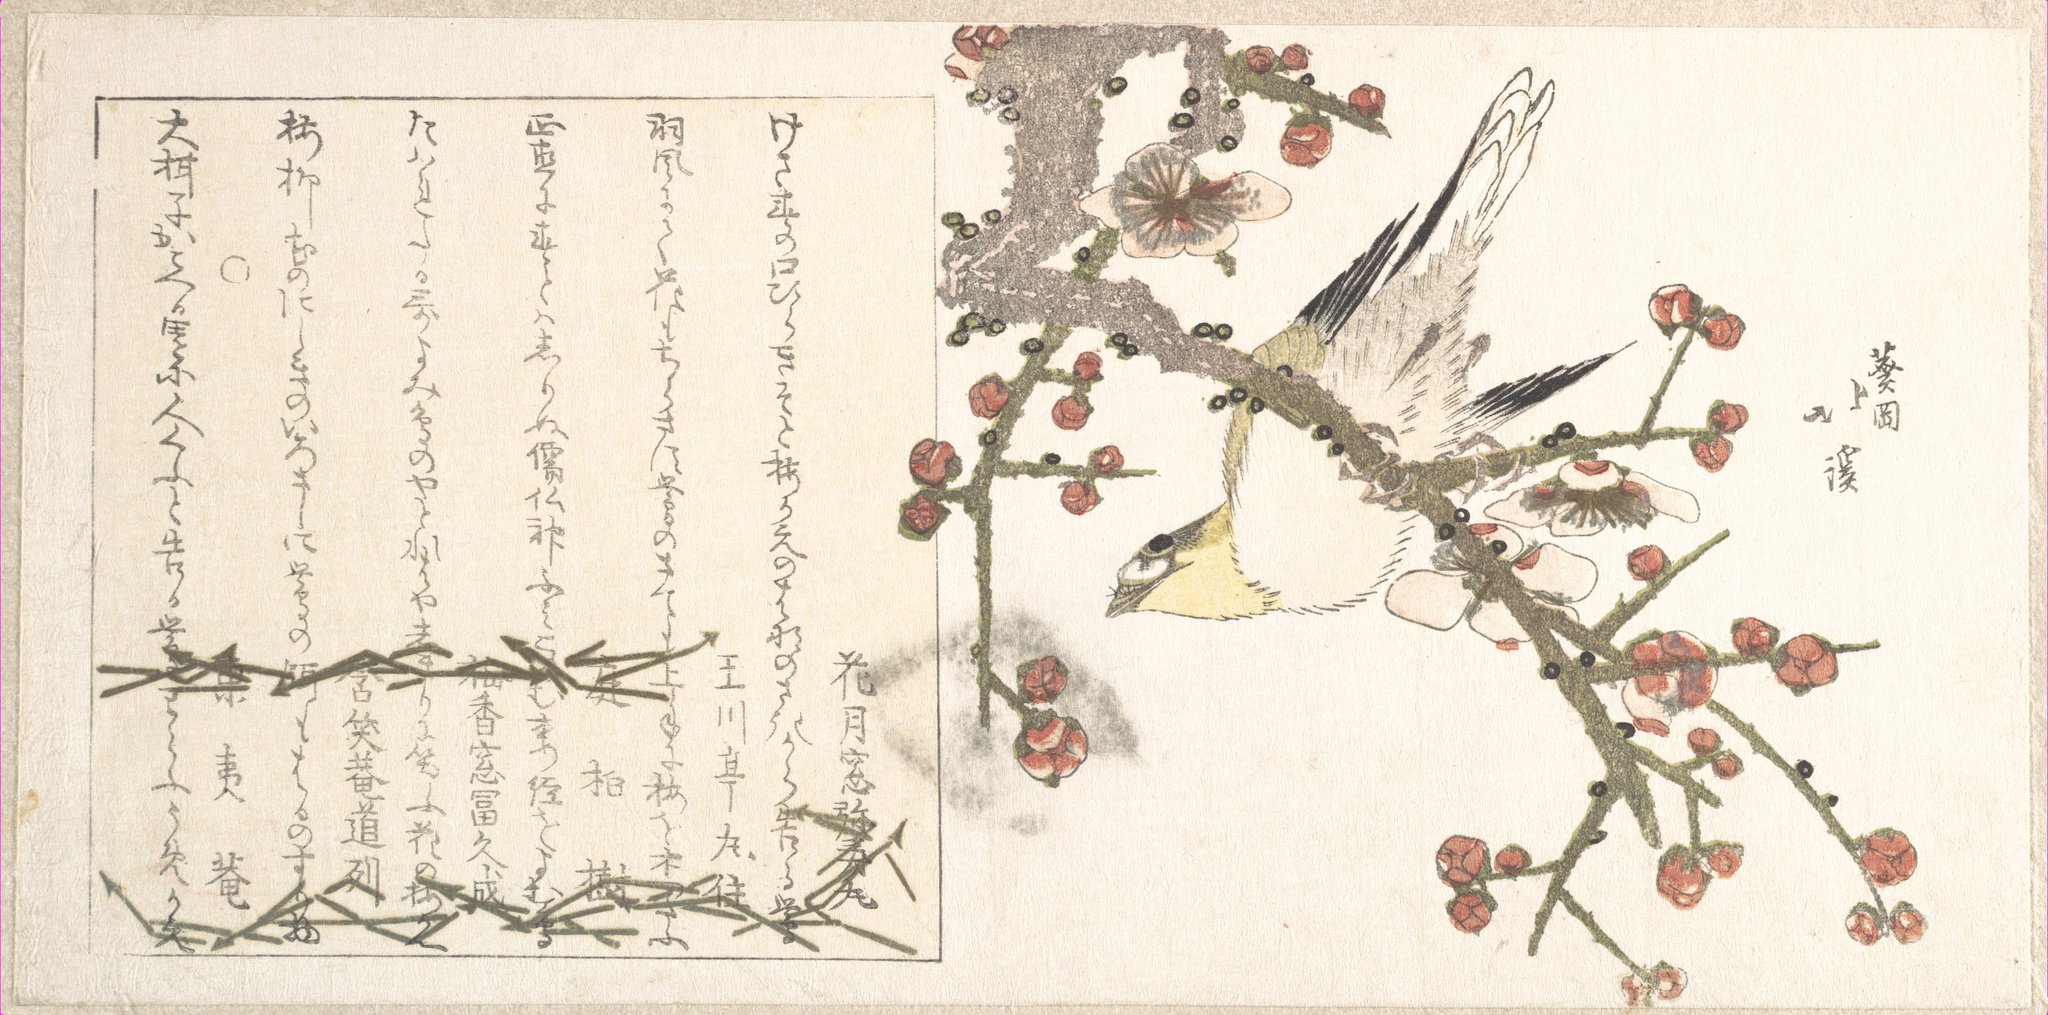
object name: woodblock print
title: Bush Warbler on a Plum Branch (Ume ni uguisu)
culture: japanese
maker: totoya hokkei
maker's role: artist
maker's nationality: japanese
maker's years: 1780-1850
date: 1801-1833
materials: ink, paper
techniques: surimono, woodblock print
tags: birds,flowers